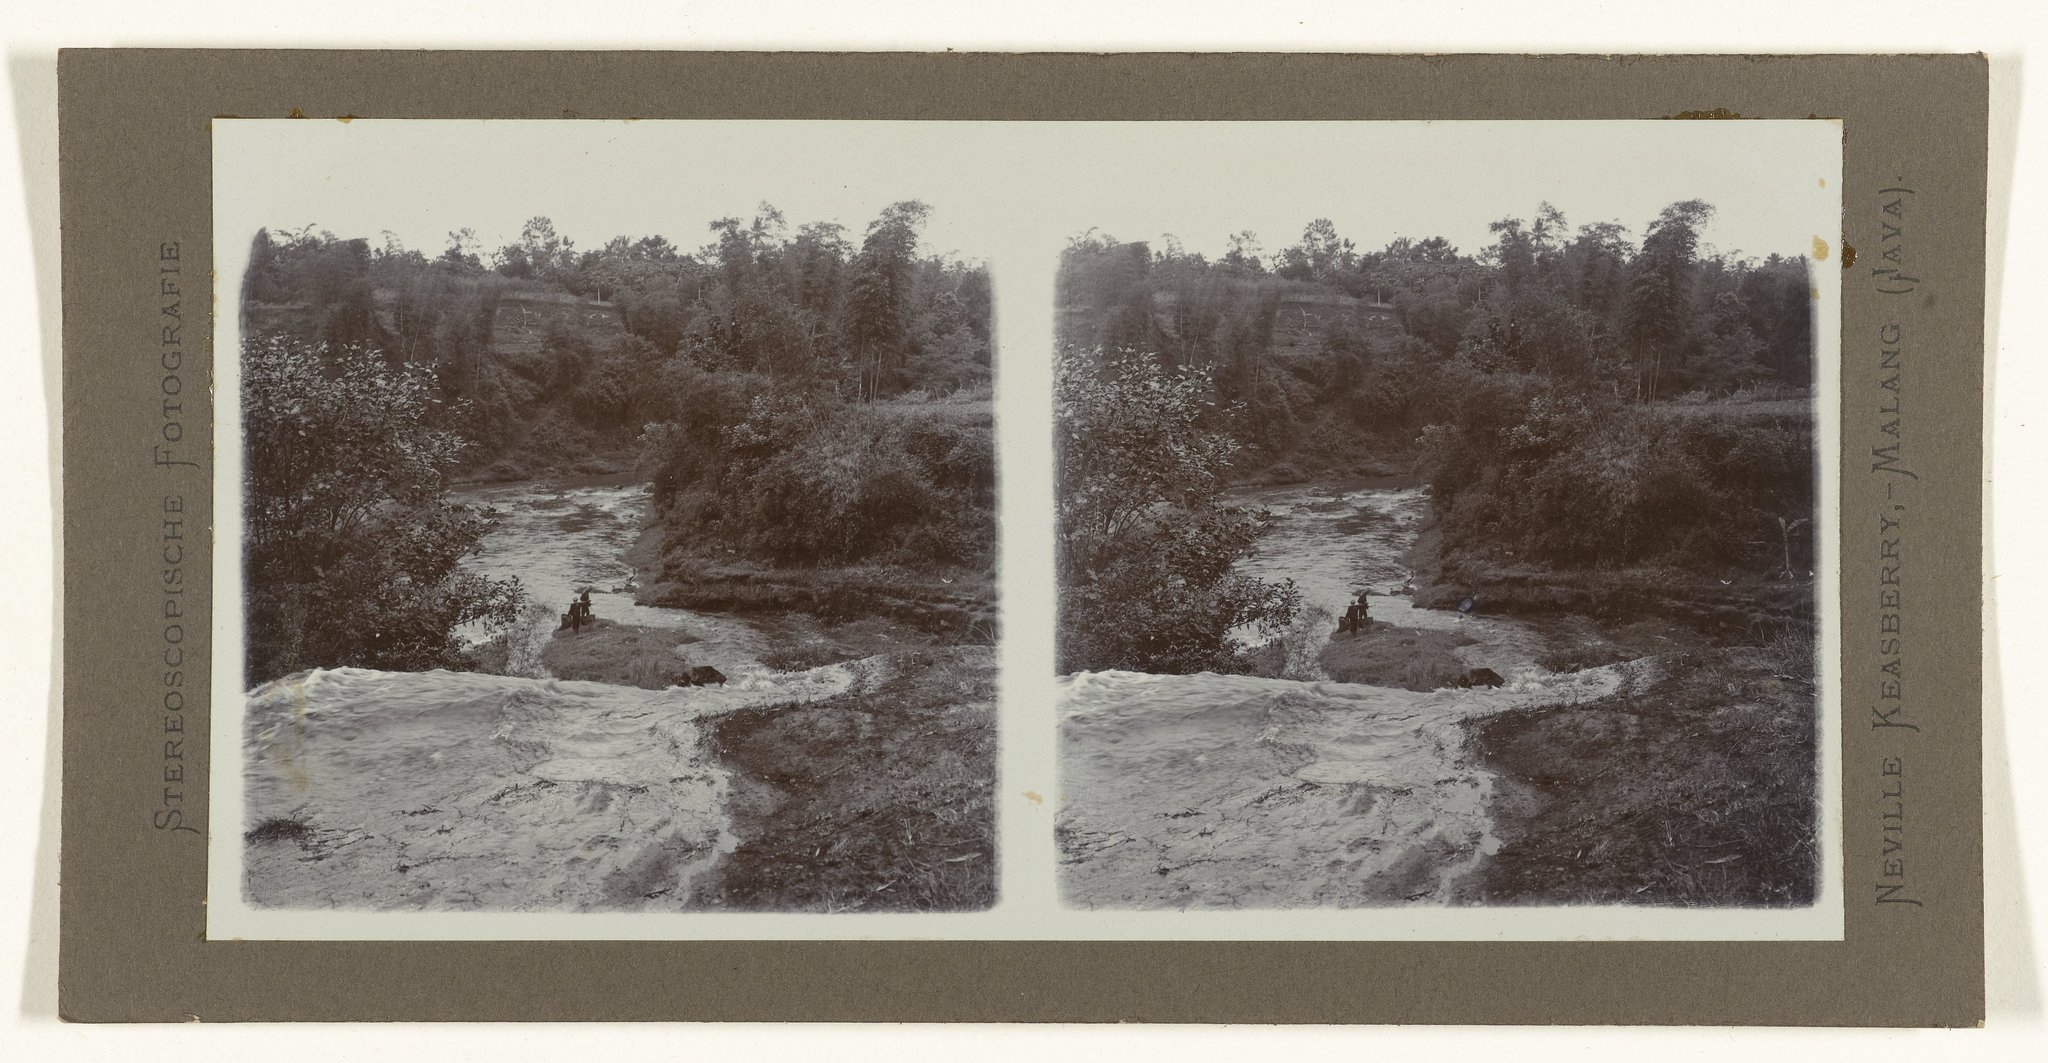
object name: stereograph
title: S 7 No 80. Boven de watervallen Kedong-Kadang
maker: neville keasberry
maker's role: fotograaf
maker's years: 1866-1944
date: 1900-1935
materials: cardboard, paper, photographic support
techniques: albumen print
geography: malang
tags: java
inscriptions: signature: ‘Neville Keasberry, Malang (Java)’, inscription: ‘Stereoscopische Fotografie’